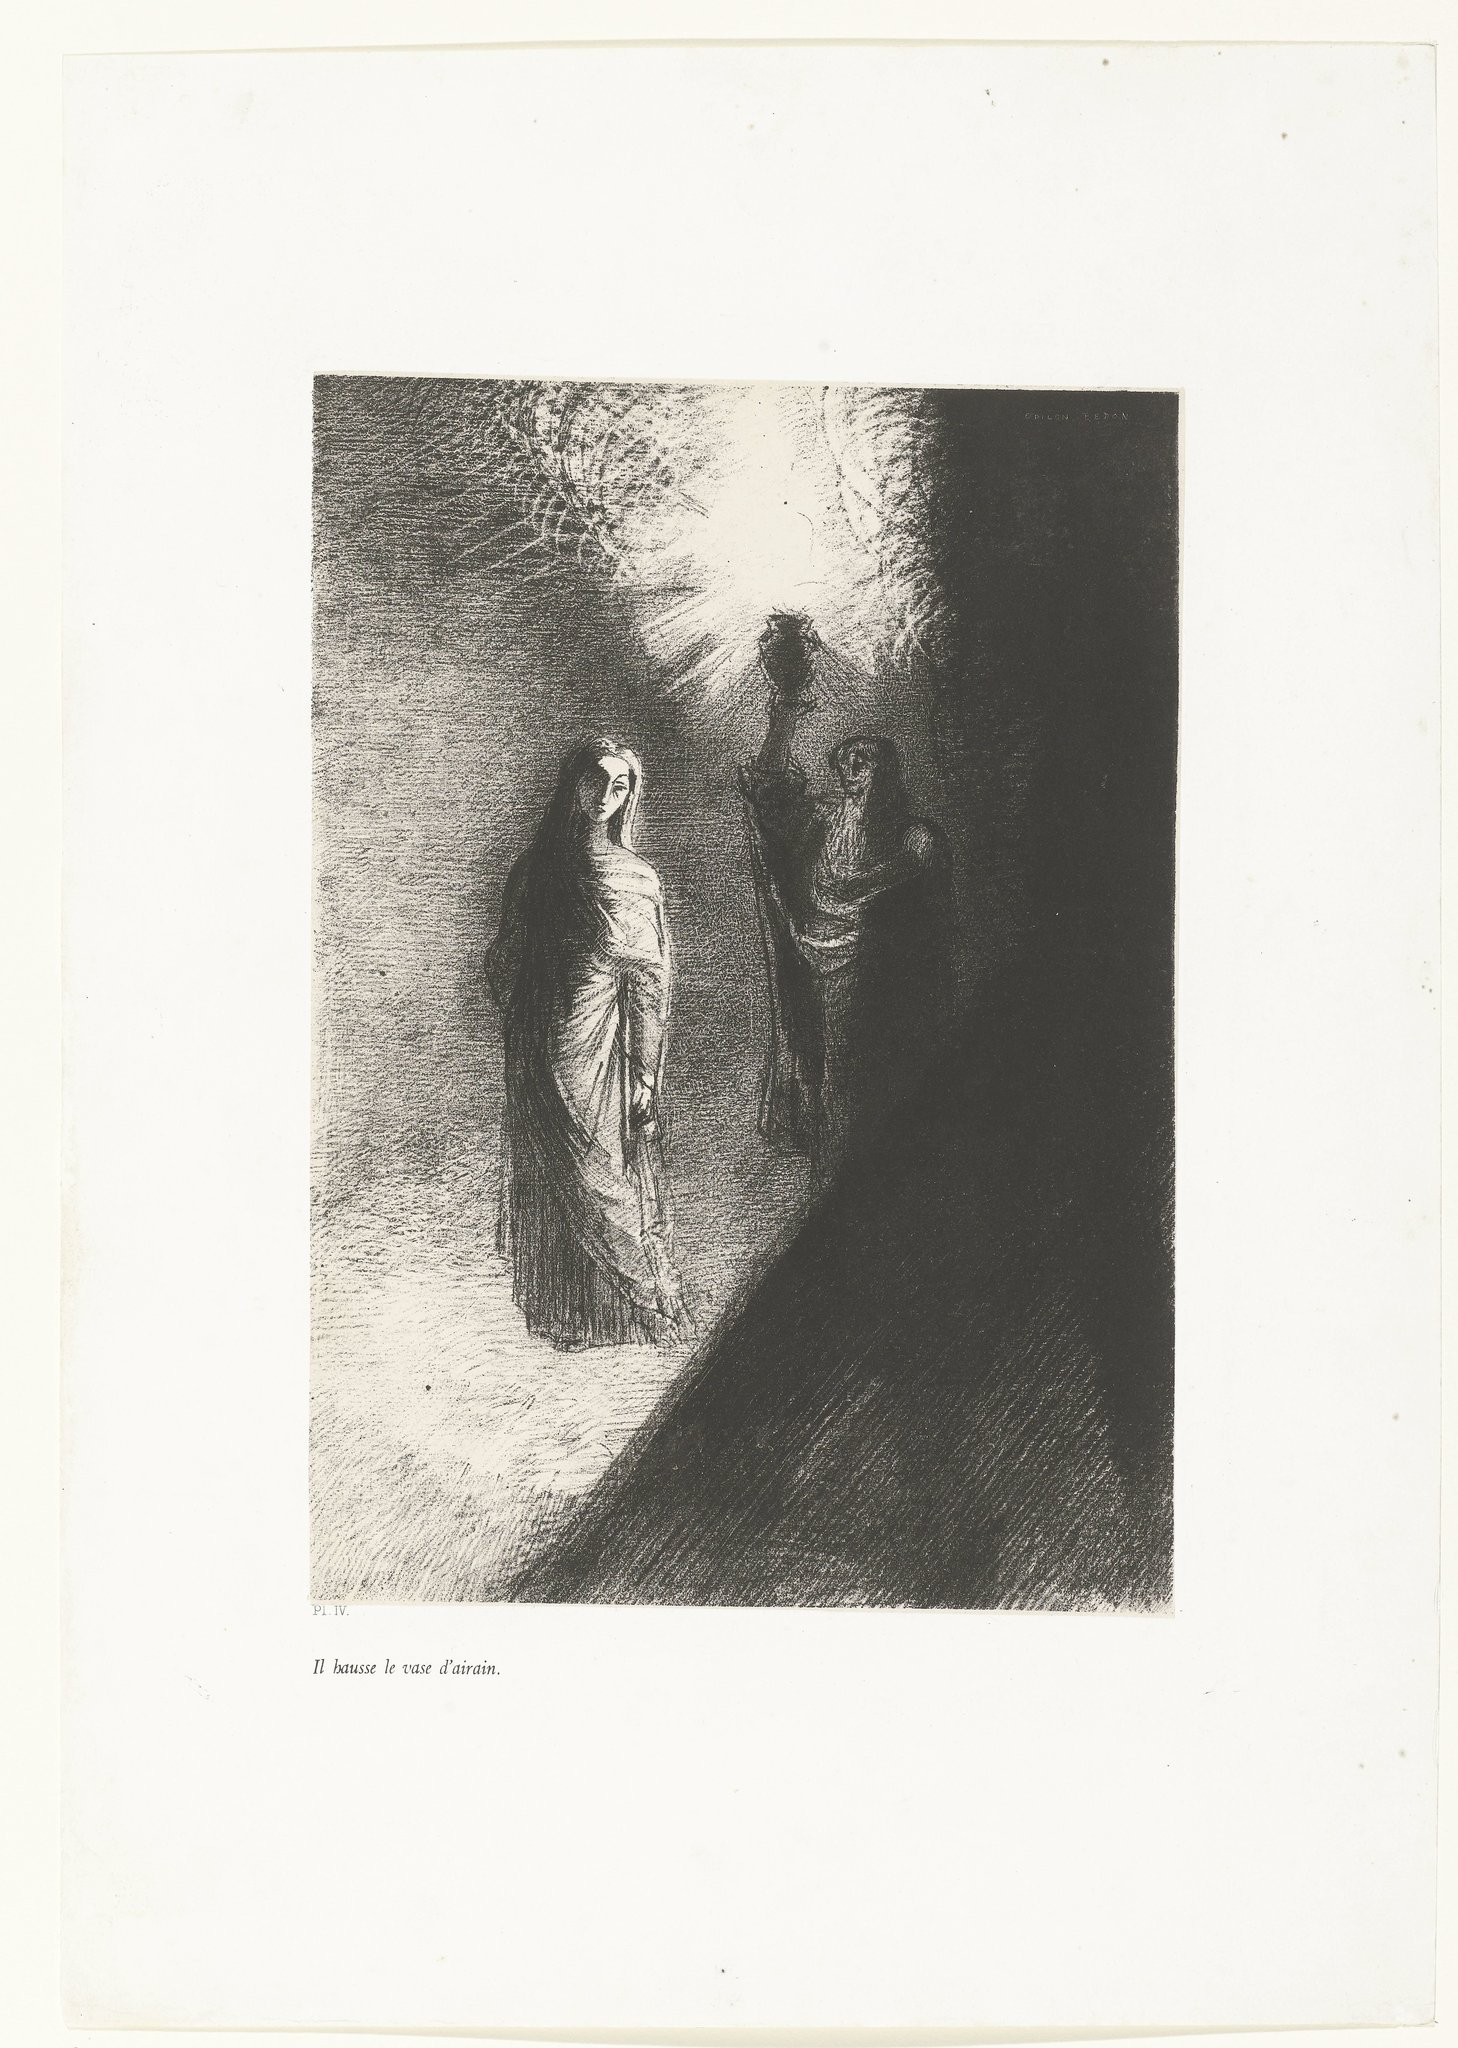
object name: print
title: Tentation de Saint-Antoine (1)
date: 1888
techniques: printmaking, lithograph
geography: paris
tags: adult woman, adult man, temptations of st. antony abbot, container of metal: bucket, can, canister, drum, tin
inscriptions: collector's mark: Lugt 2228, collector's mark: Lugt 2760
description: Een vrouw en een man, staand. De man houdt een vaas omhoog waaruit lichtstralen komen. Vierde prent van tien uit de eerste serie illustraties voor Gustave Flauberts De verzoeking van de heilige Antonius.